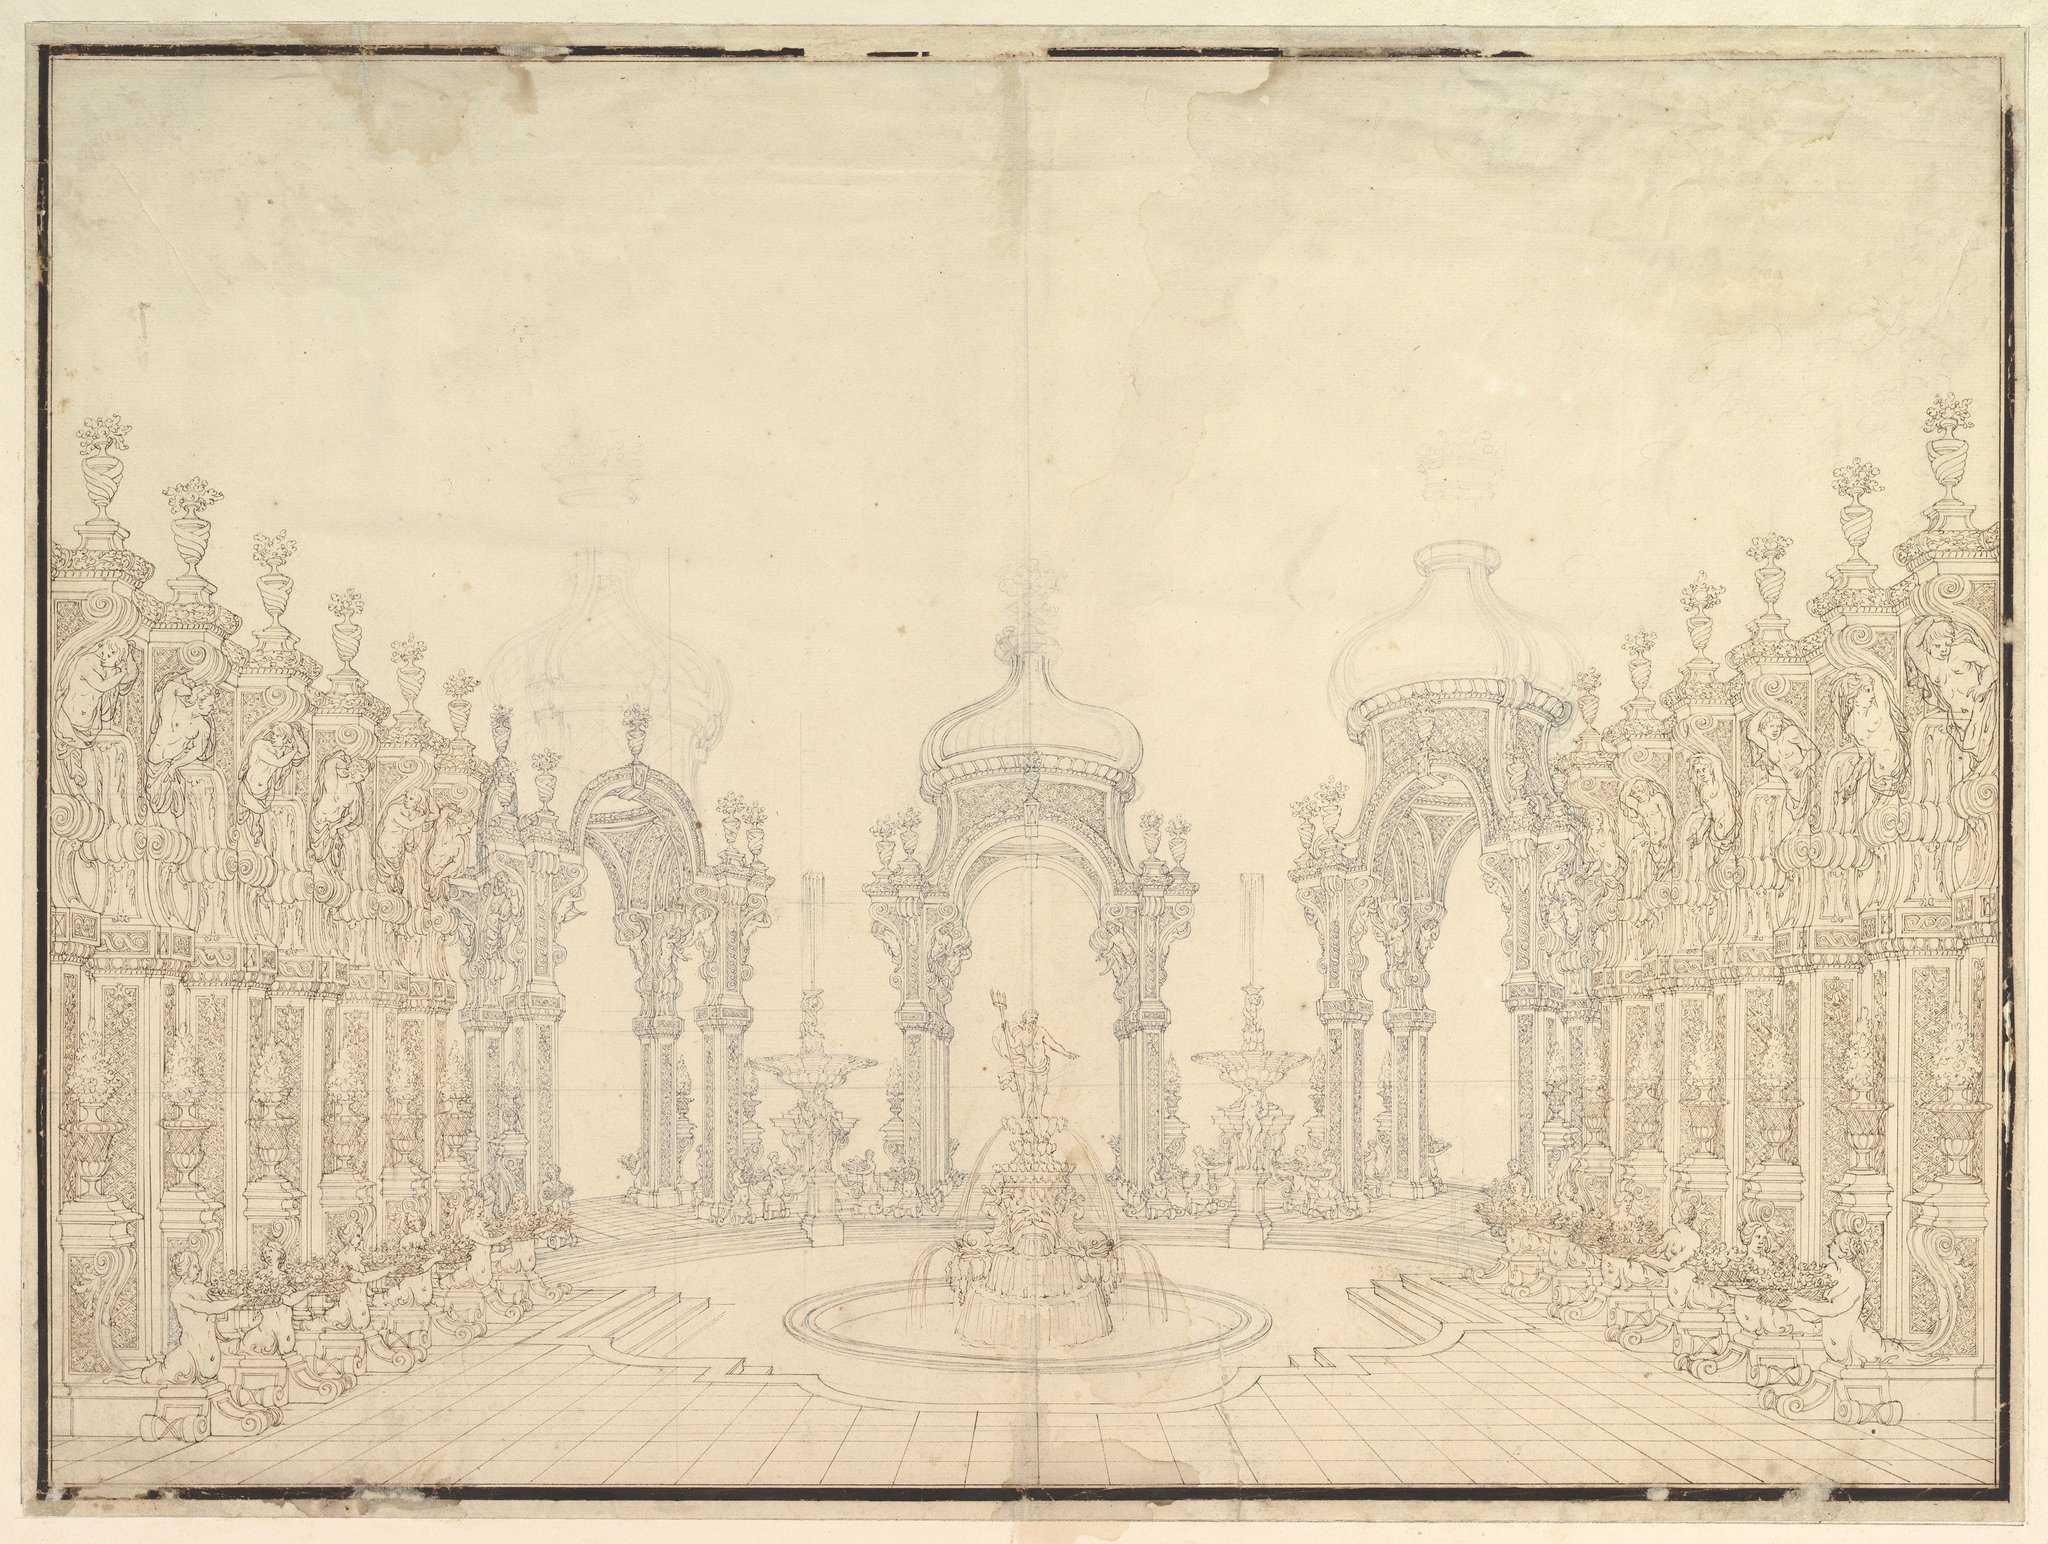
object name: drawing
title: Designs for Stage Set: Three Pavillions in Background with "Oriental" (Ogival) Cupolas with Two Small Fountains between Them; in Foreground, a large Fountain with Dolphins Surmounted by Neptune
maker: giuseppe galli bibiena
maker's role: artist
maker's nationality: italian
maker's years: 1696-1756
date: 1696-1756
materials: chalk, ink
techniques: pen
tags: fountains,dolphins,stage design